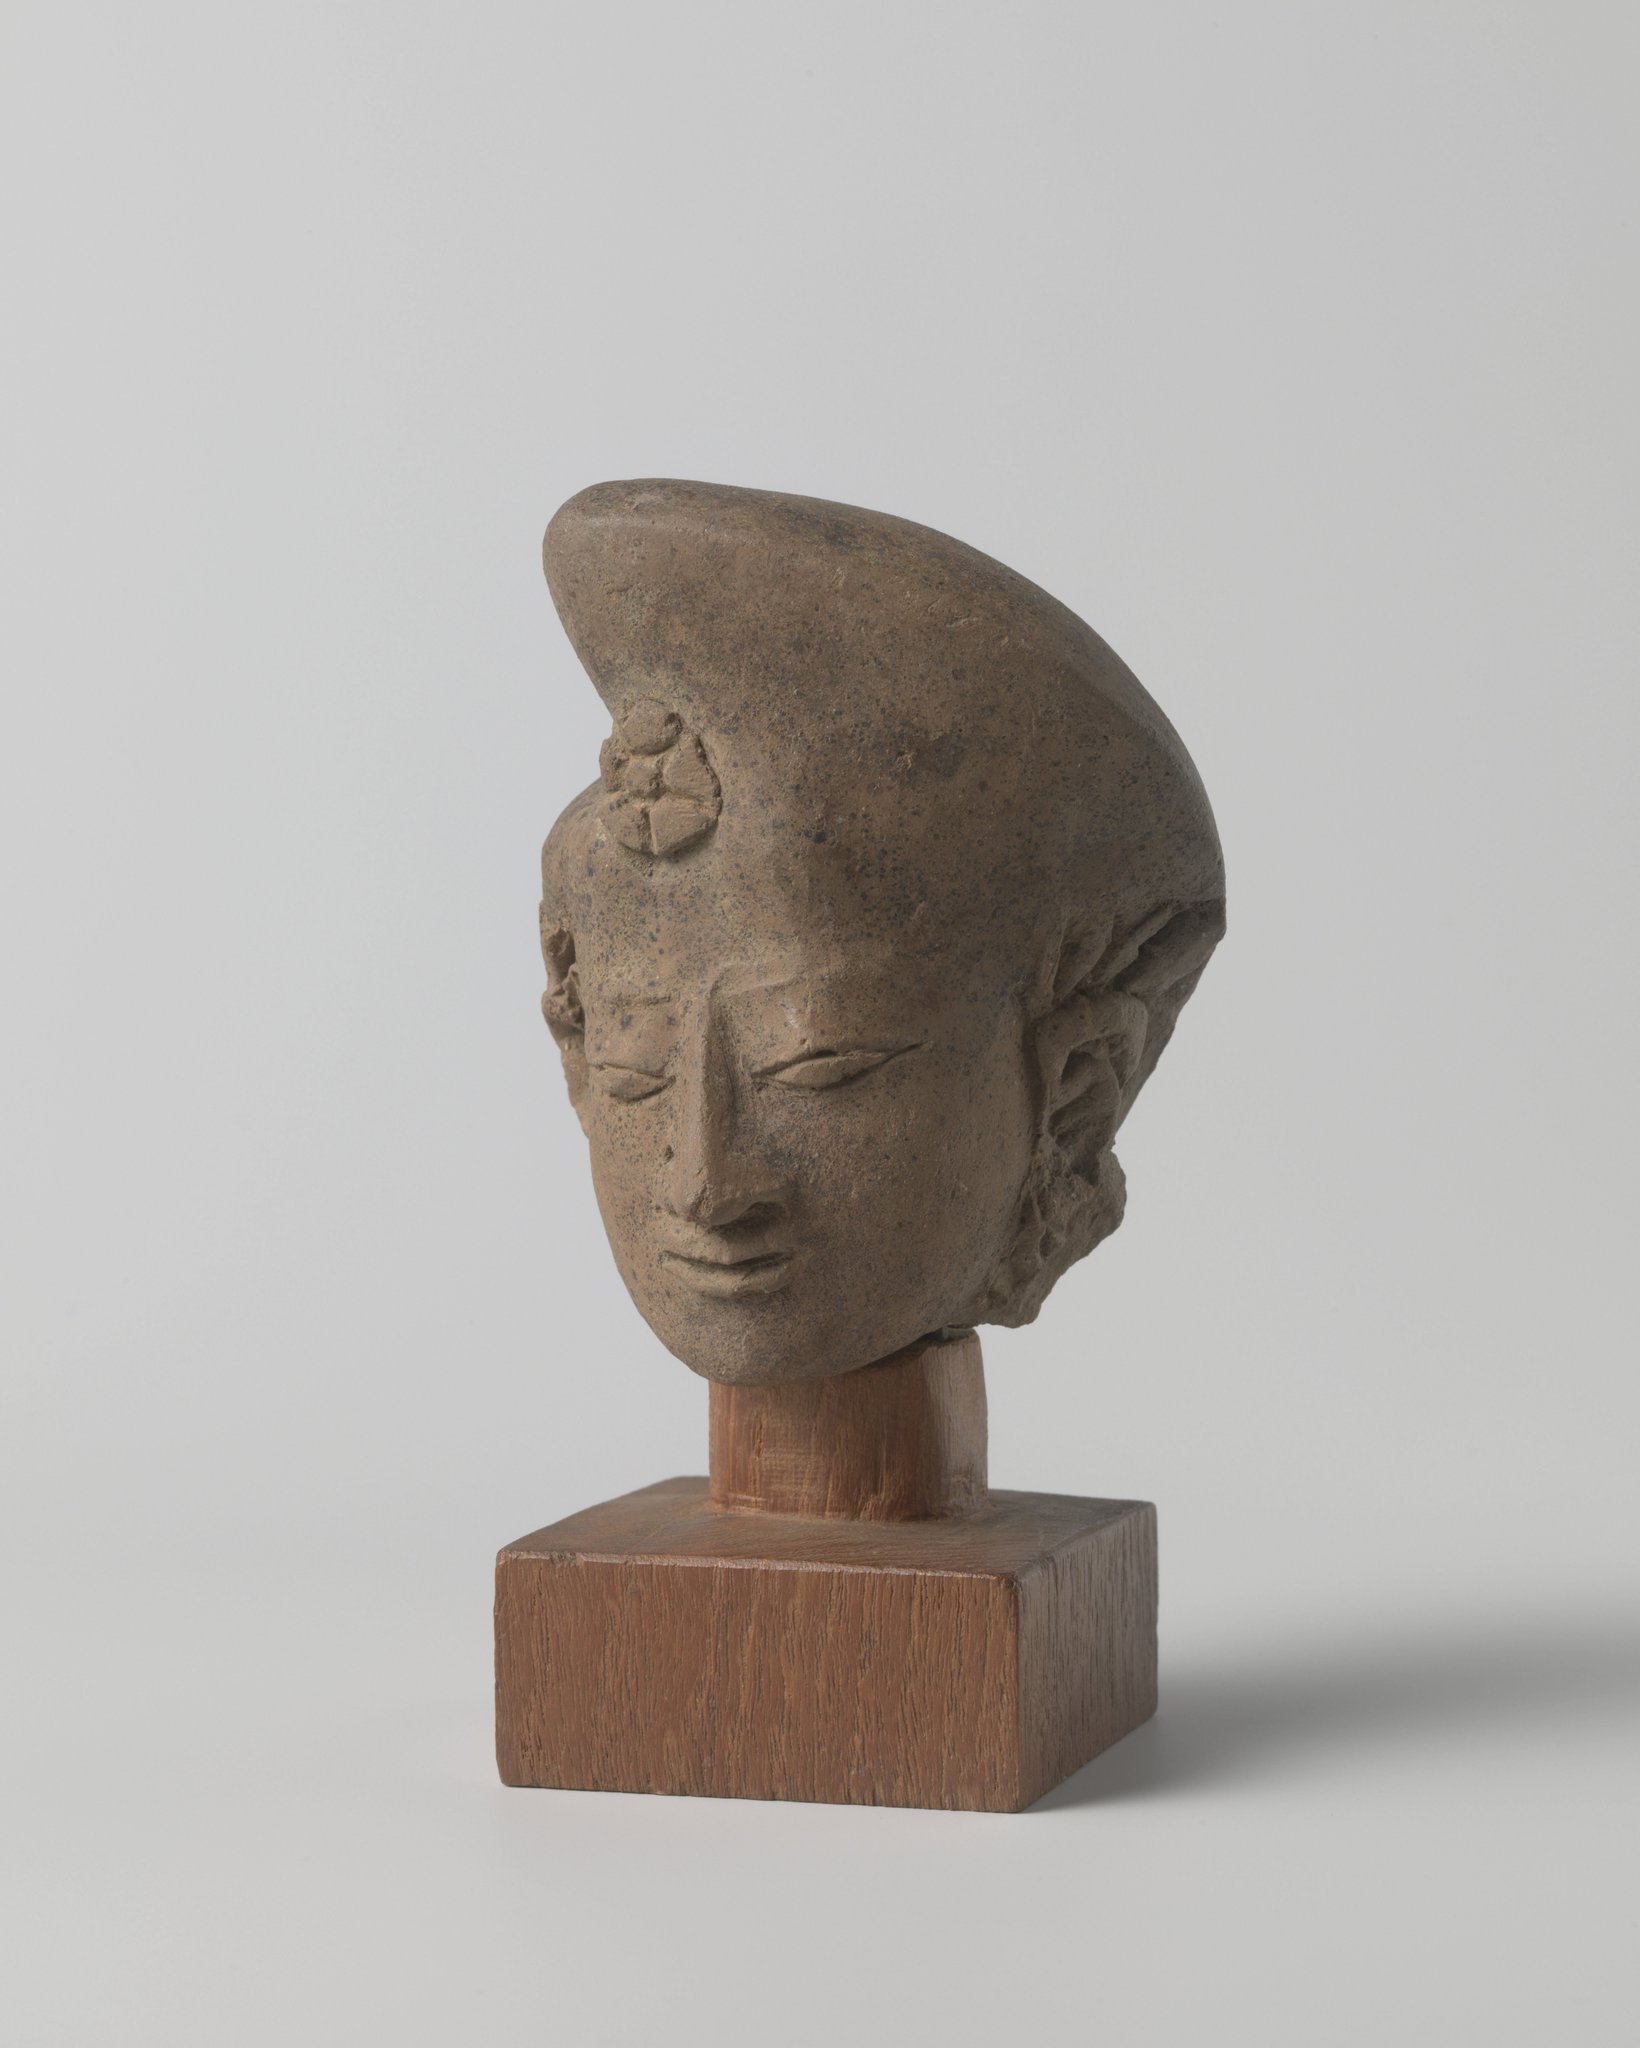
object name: sculpture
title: Beeldhouwwerk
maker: Anonymous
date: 1300-1500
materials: terracotta, wood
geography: indonesia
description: Fragment (hoofd) van vrouw (?), met hoog eenzijdig kapsel. Op sokkel.